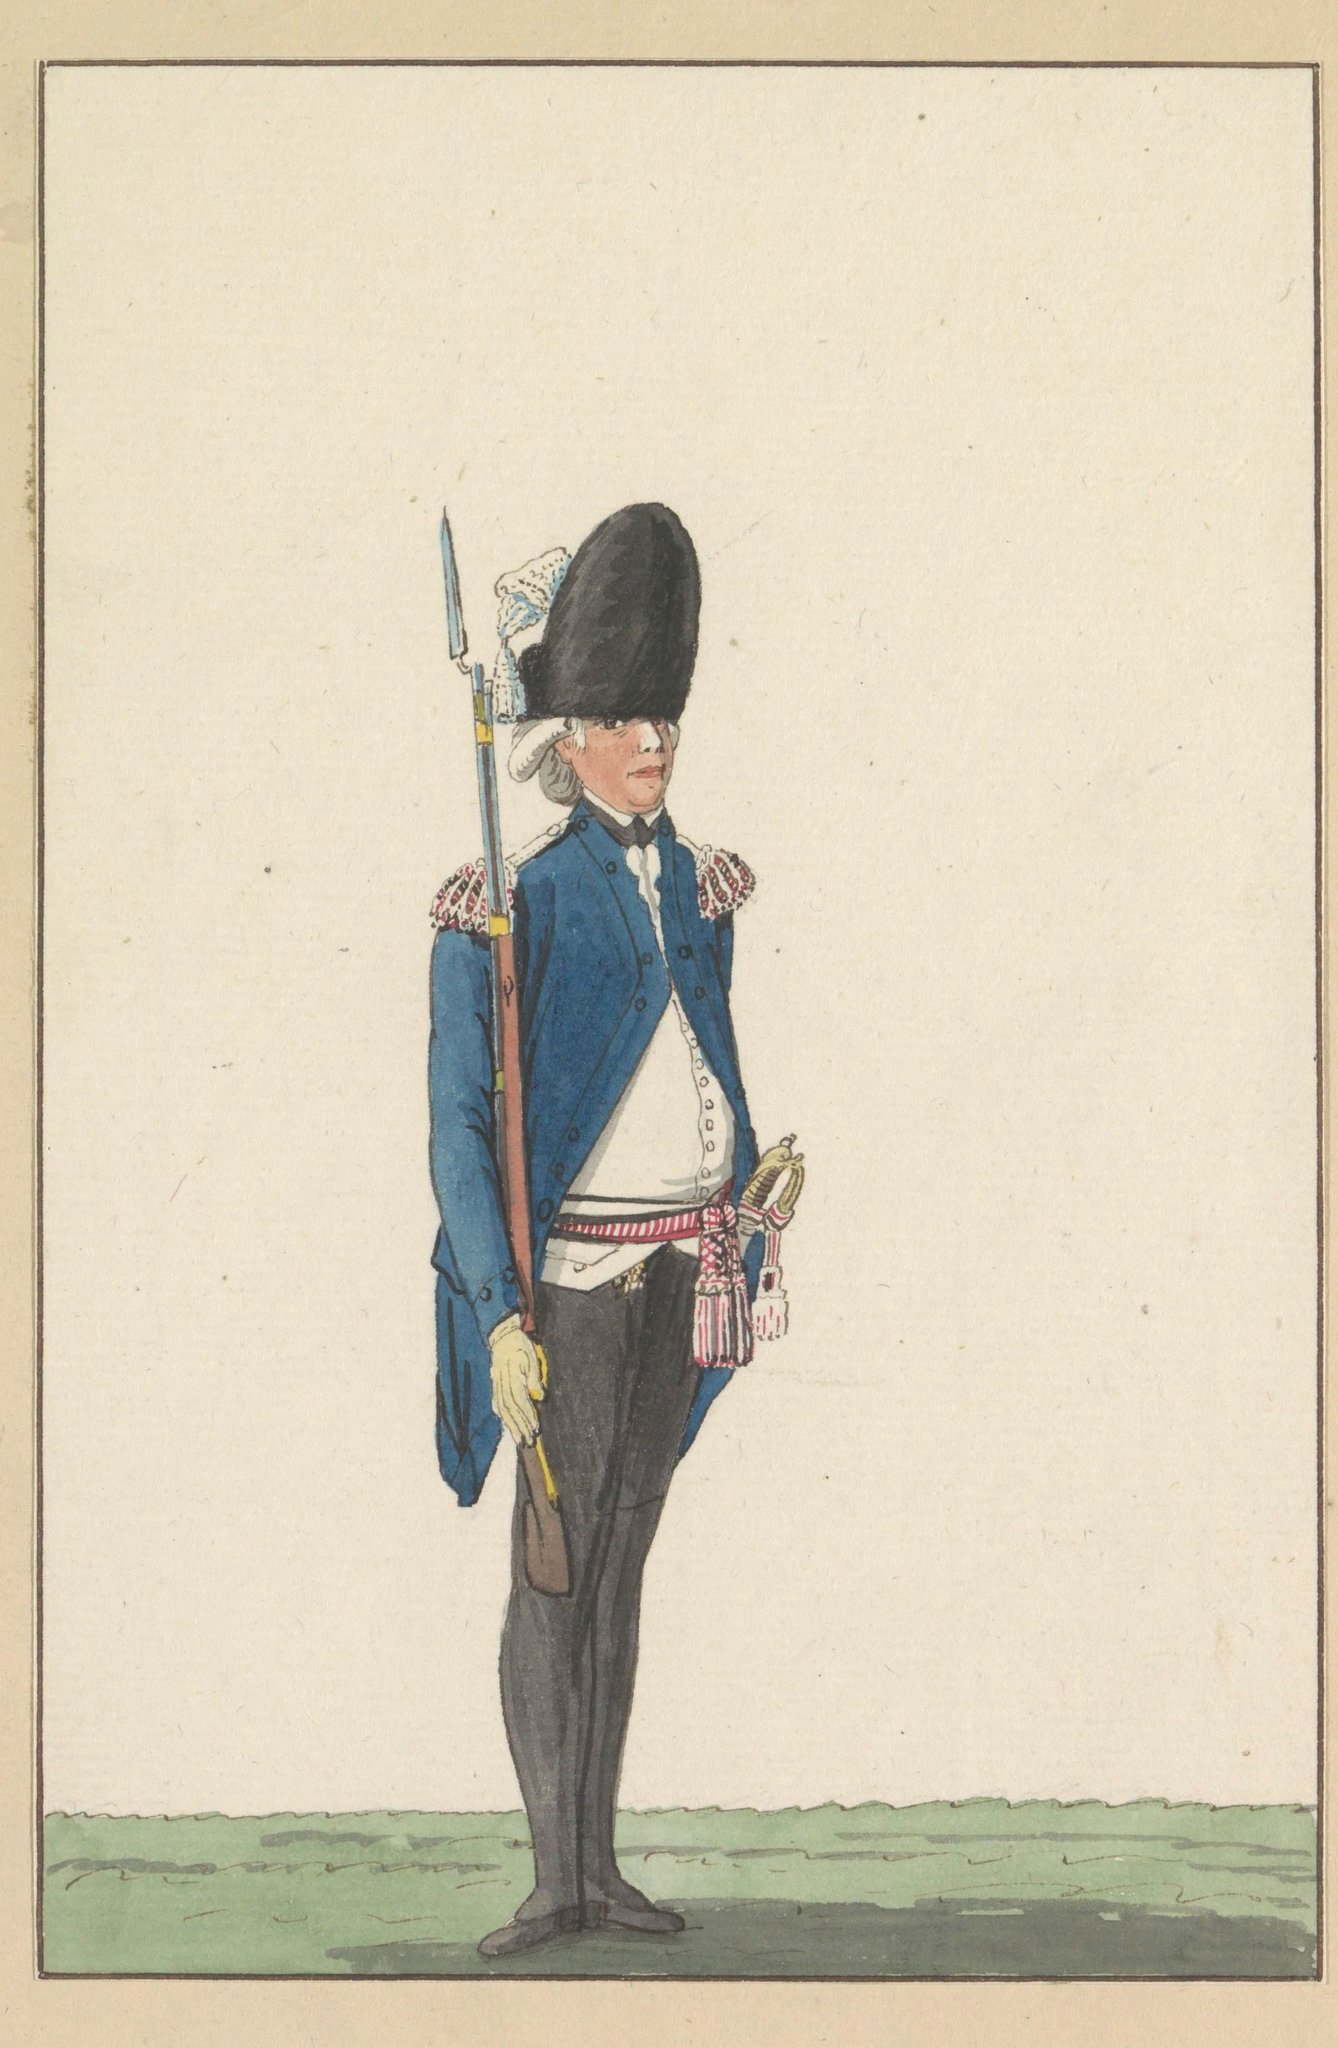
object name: drawing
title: Onderofficier van het Genootschap tot Nut der Schutterij te Amsterdam, 1787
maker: Anonymous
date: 1787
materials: paper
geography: amsterdam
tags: (military) uniforms (+ citizen soldiery, civil guard, citizen militia), amsterdam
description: Onderofficier, staande in de houding met het geweer in de rechterhand. Onderdeel van het album met veertien ingeplakte gekleurde tekeningen van de uniformen van schutters van het patriotse Genootschap tot Nut der Schutterij te Amsterdam in het jaar 1787.